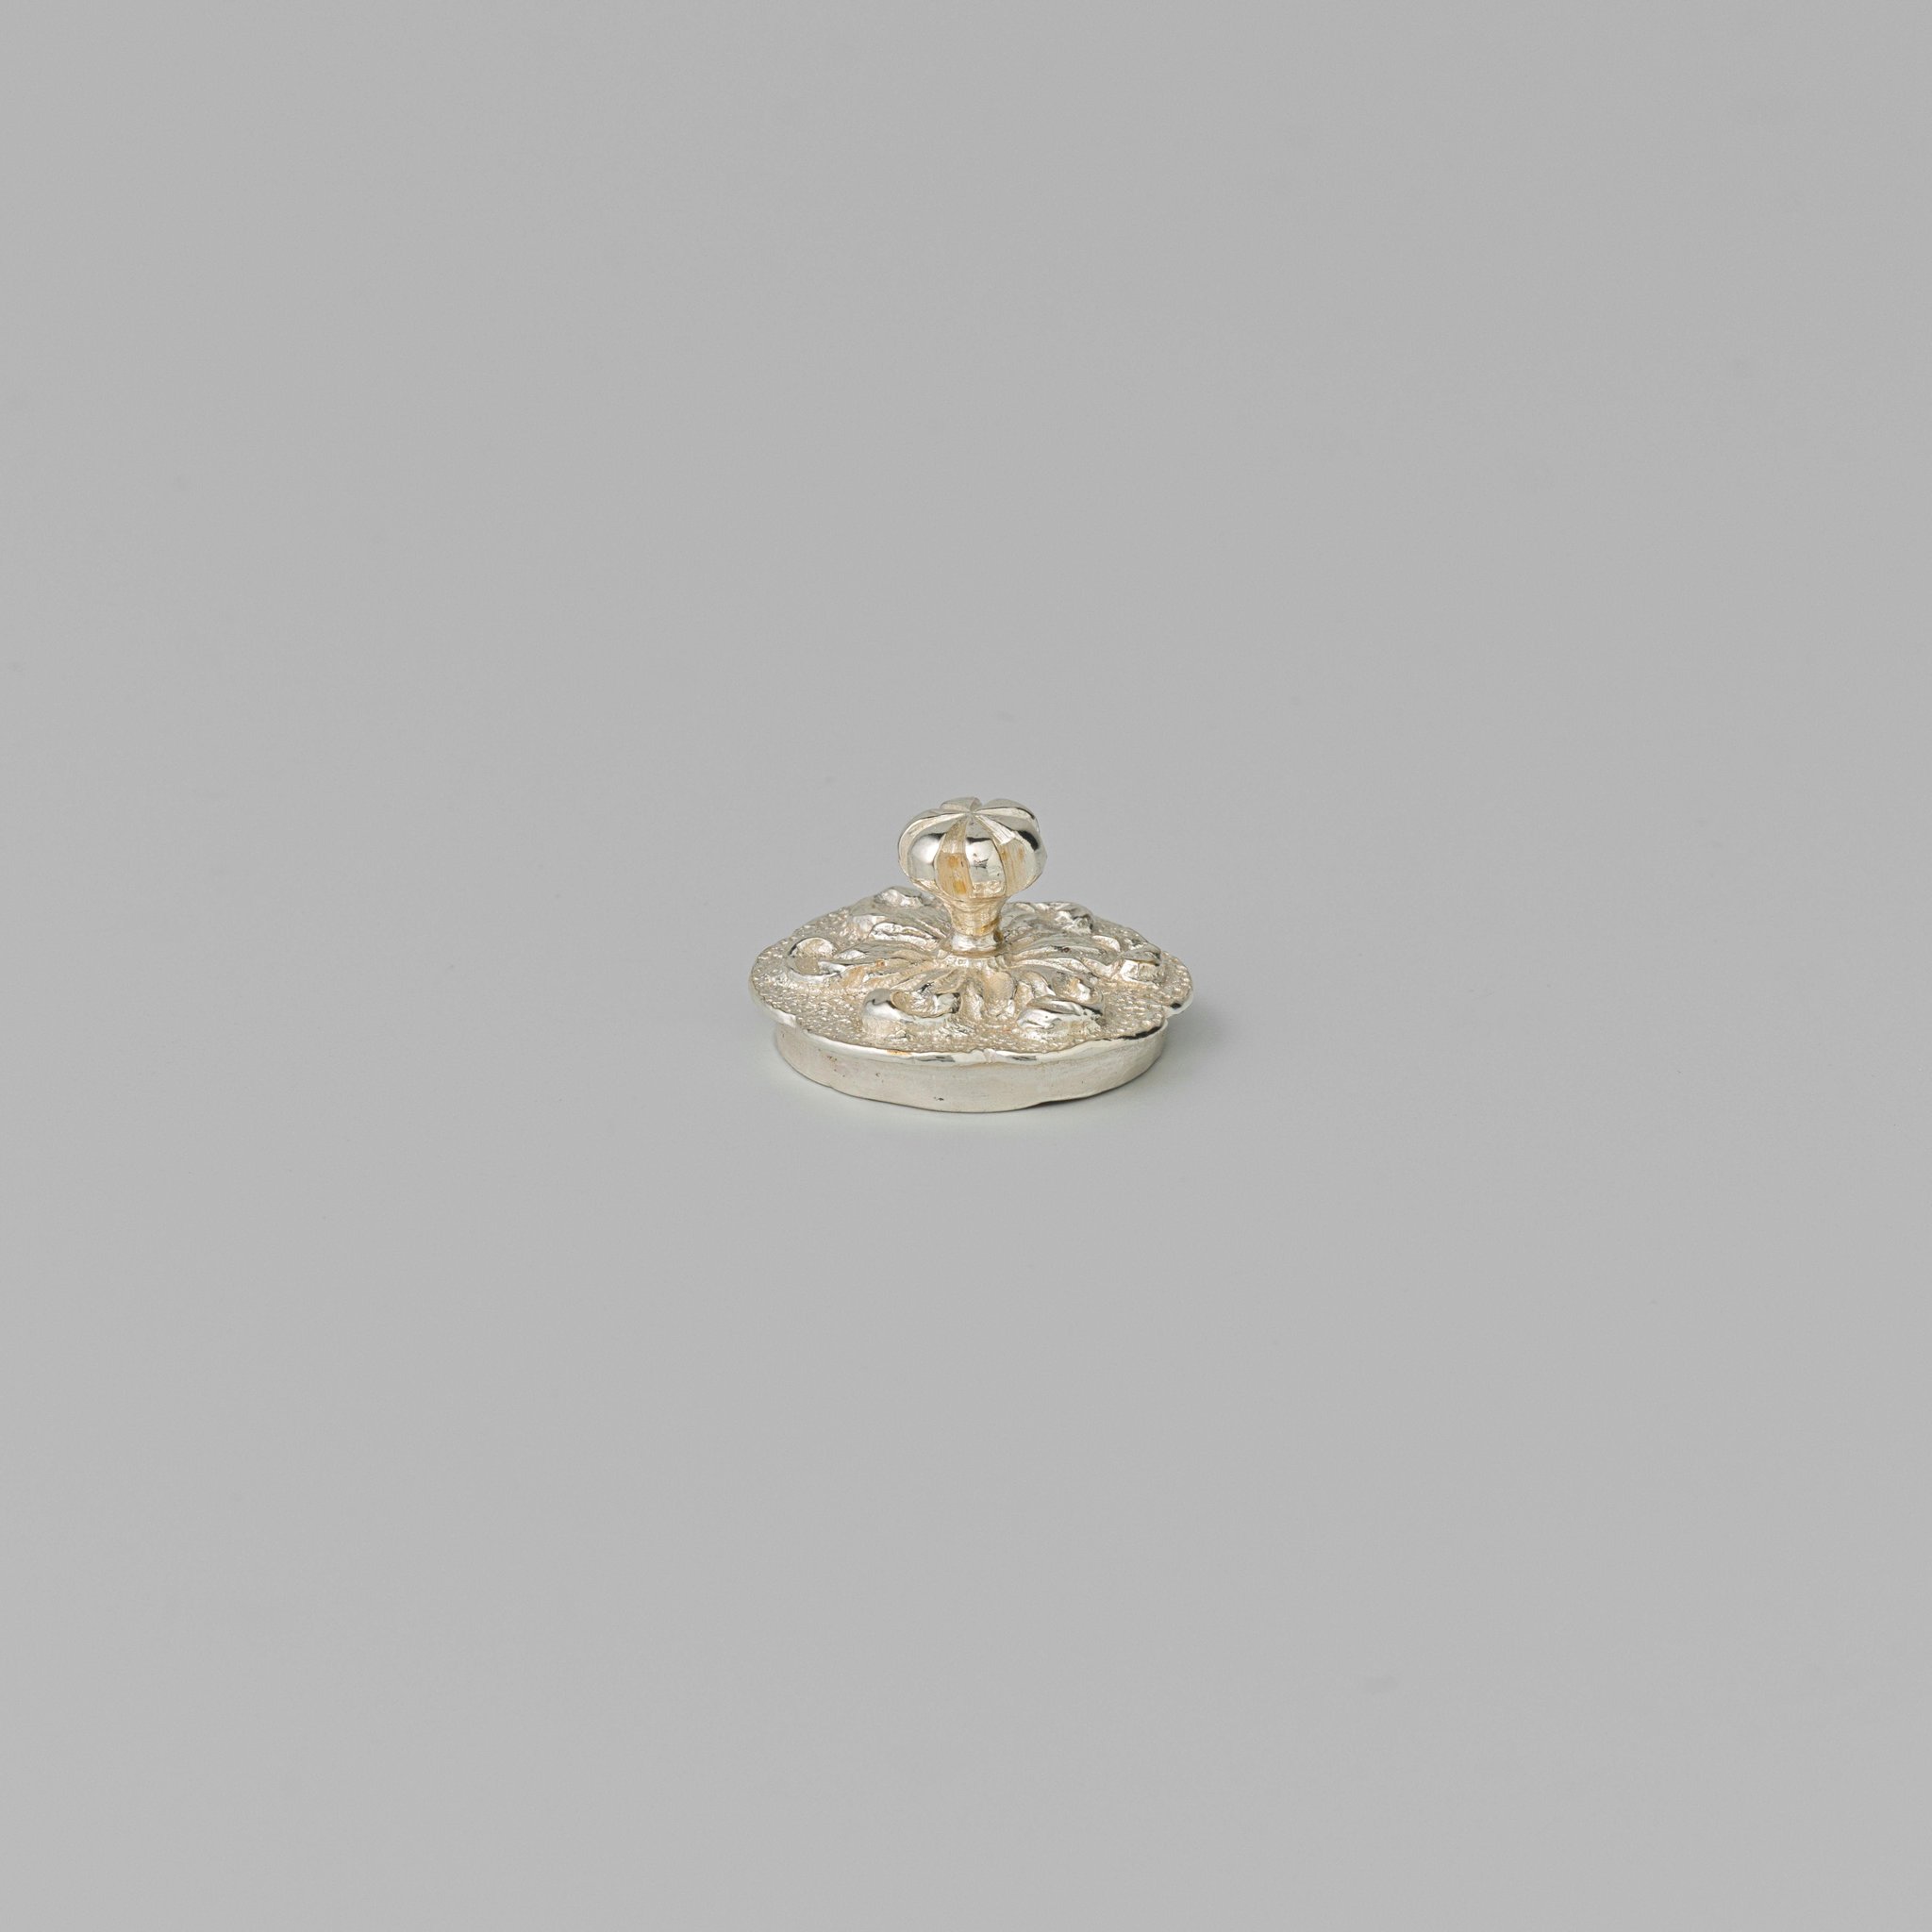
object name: lid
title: Deksel van zilver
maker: Anonymous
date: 1675-1700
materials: silver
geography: amsterdam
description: Deksel van zilver, zeslobbig, met hoge geschulpte knop en bladversiering in reliëf op geruwde grond.